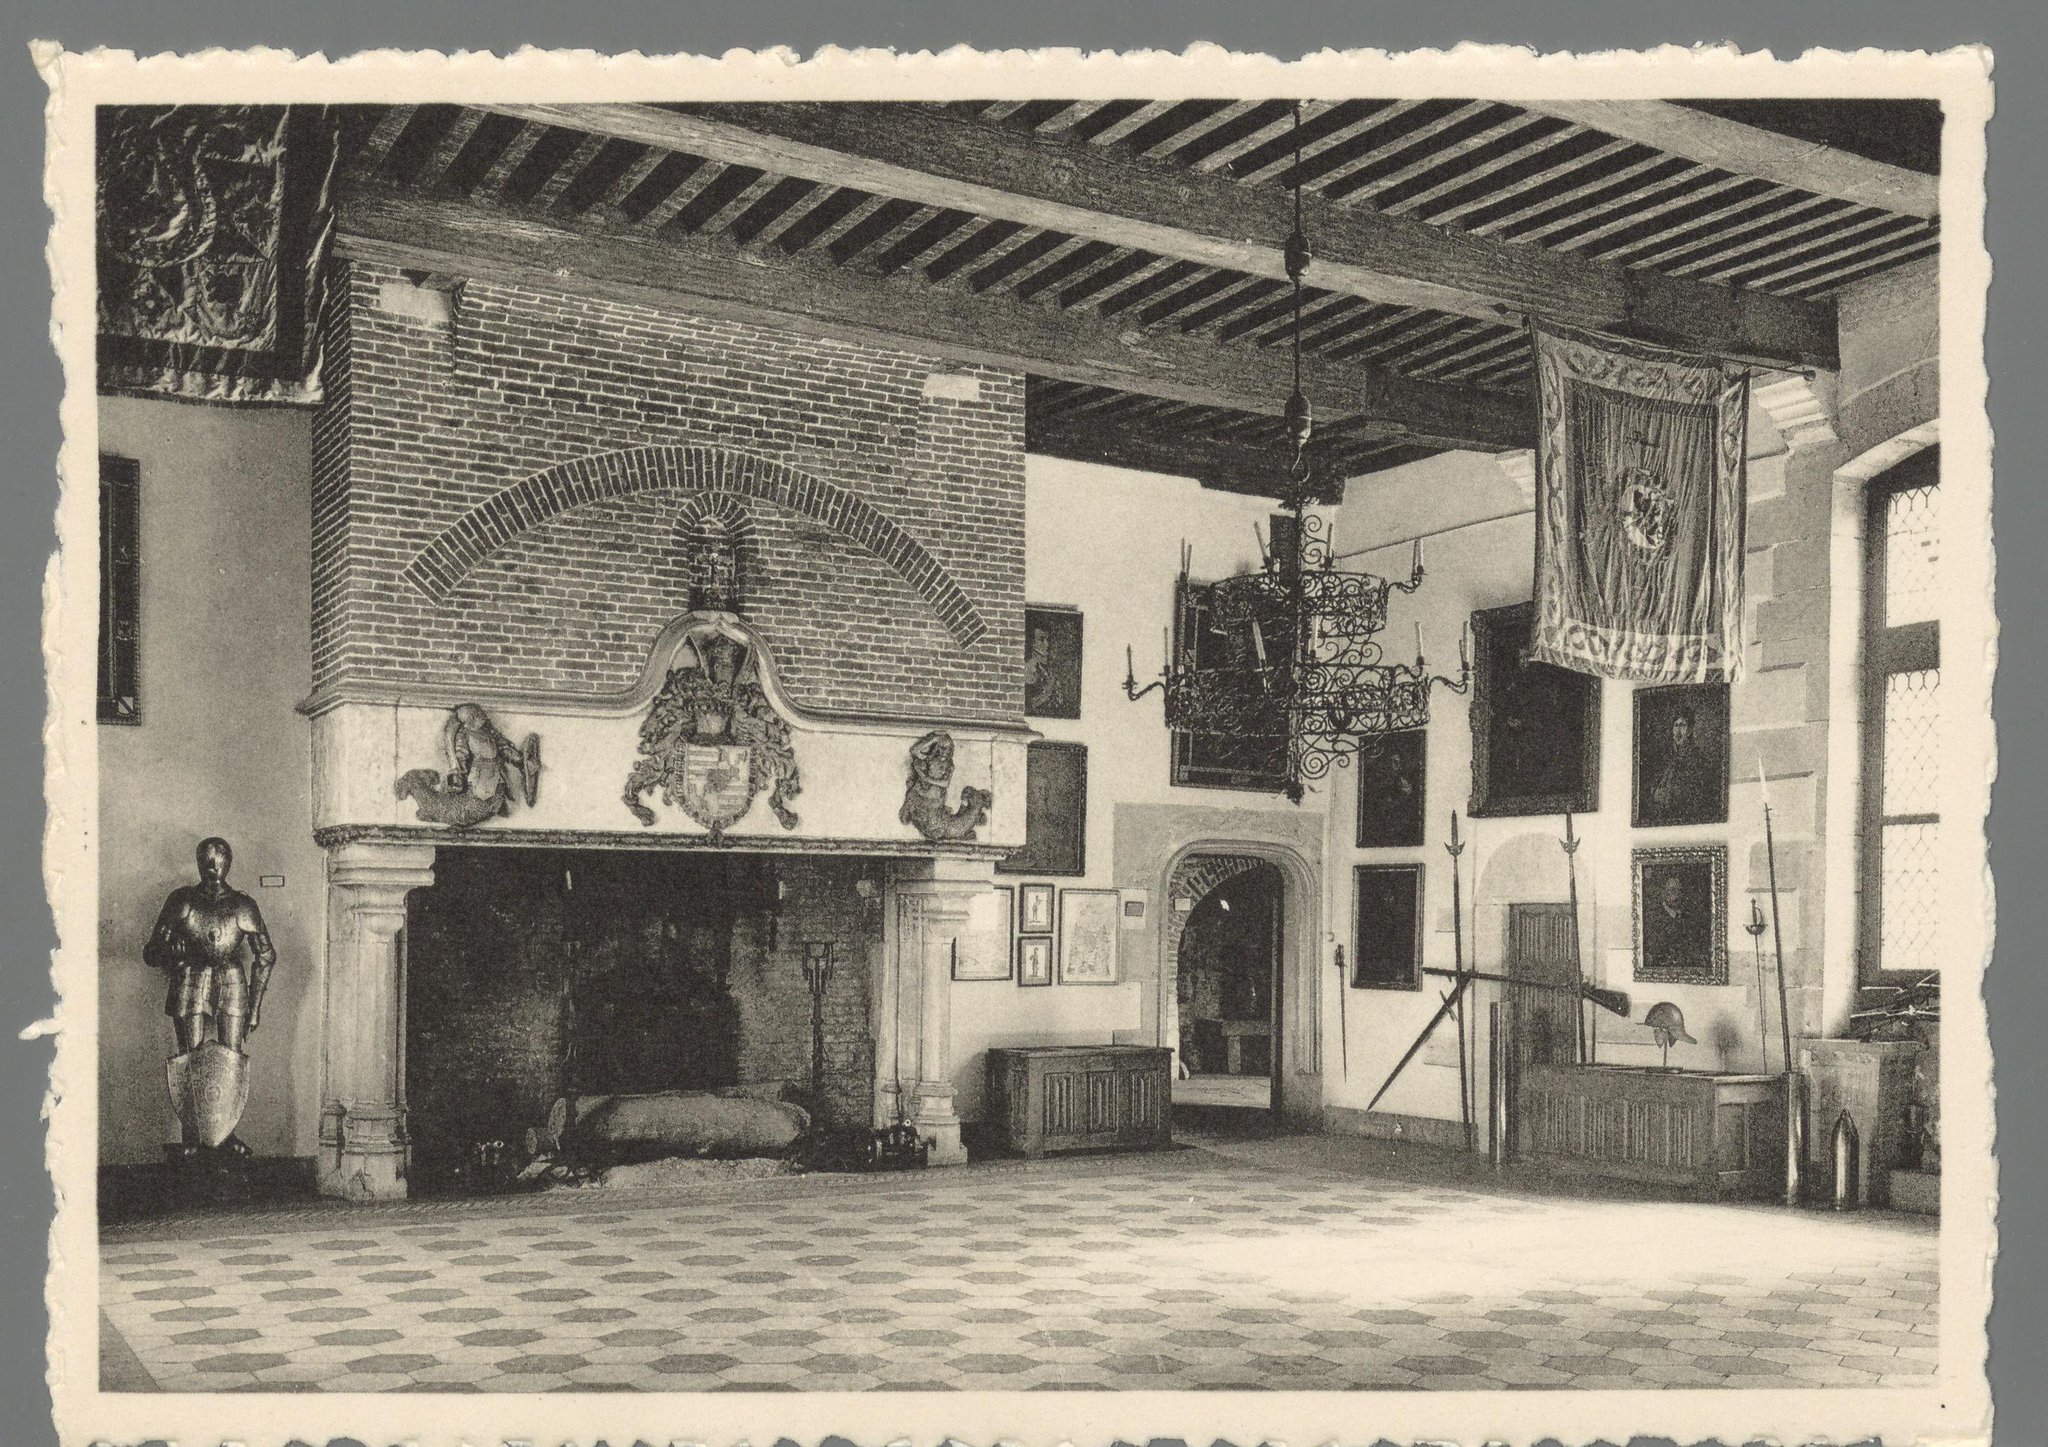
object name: photomechanical print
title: Château d'Ecausinnes-Lalaing (XIVe siècle)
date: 1913-1950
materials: cardboard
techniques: photograph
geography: ecaussinnes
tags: castle, permanent exhibition, museum, interior ~ representation of a building